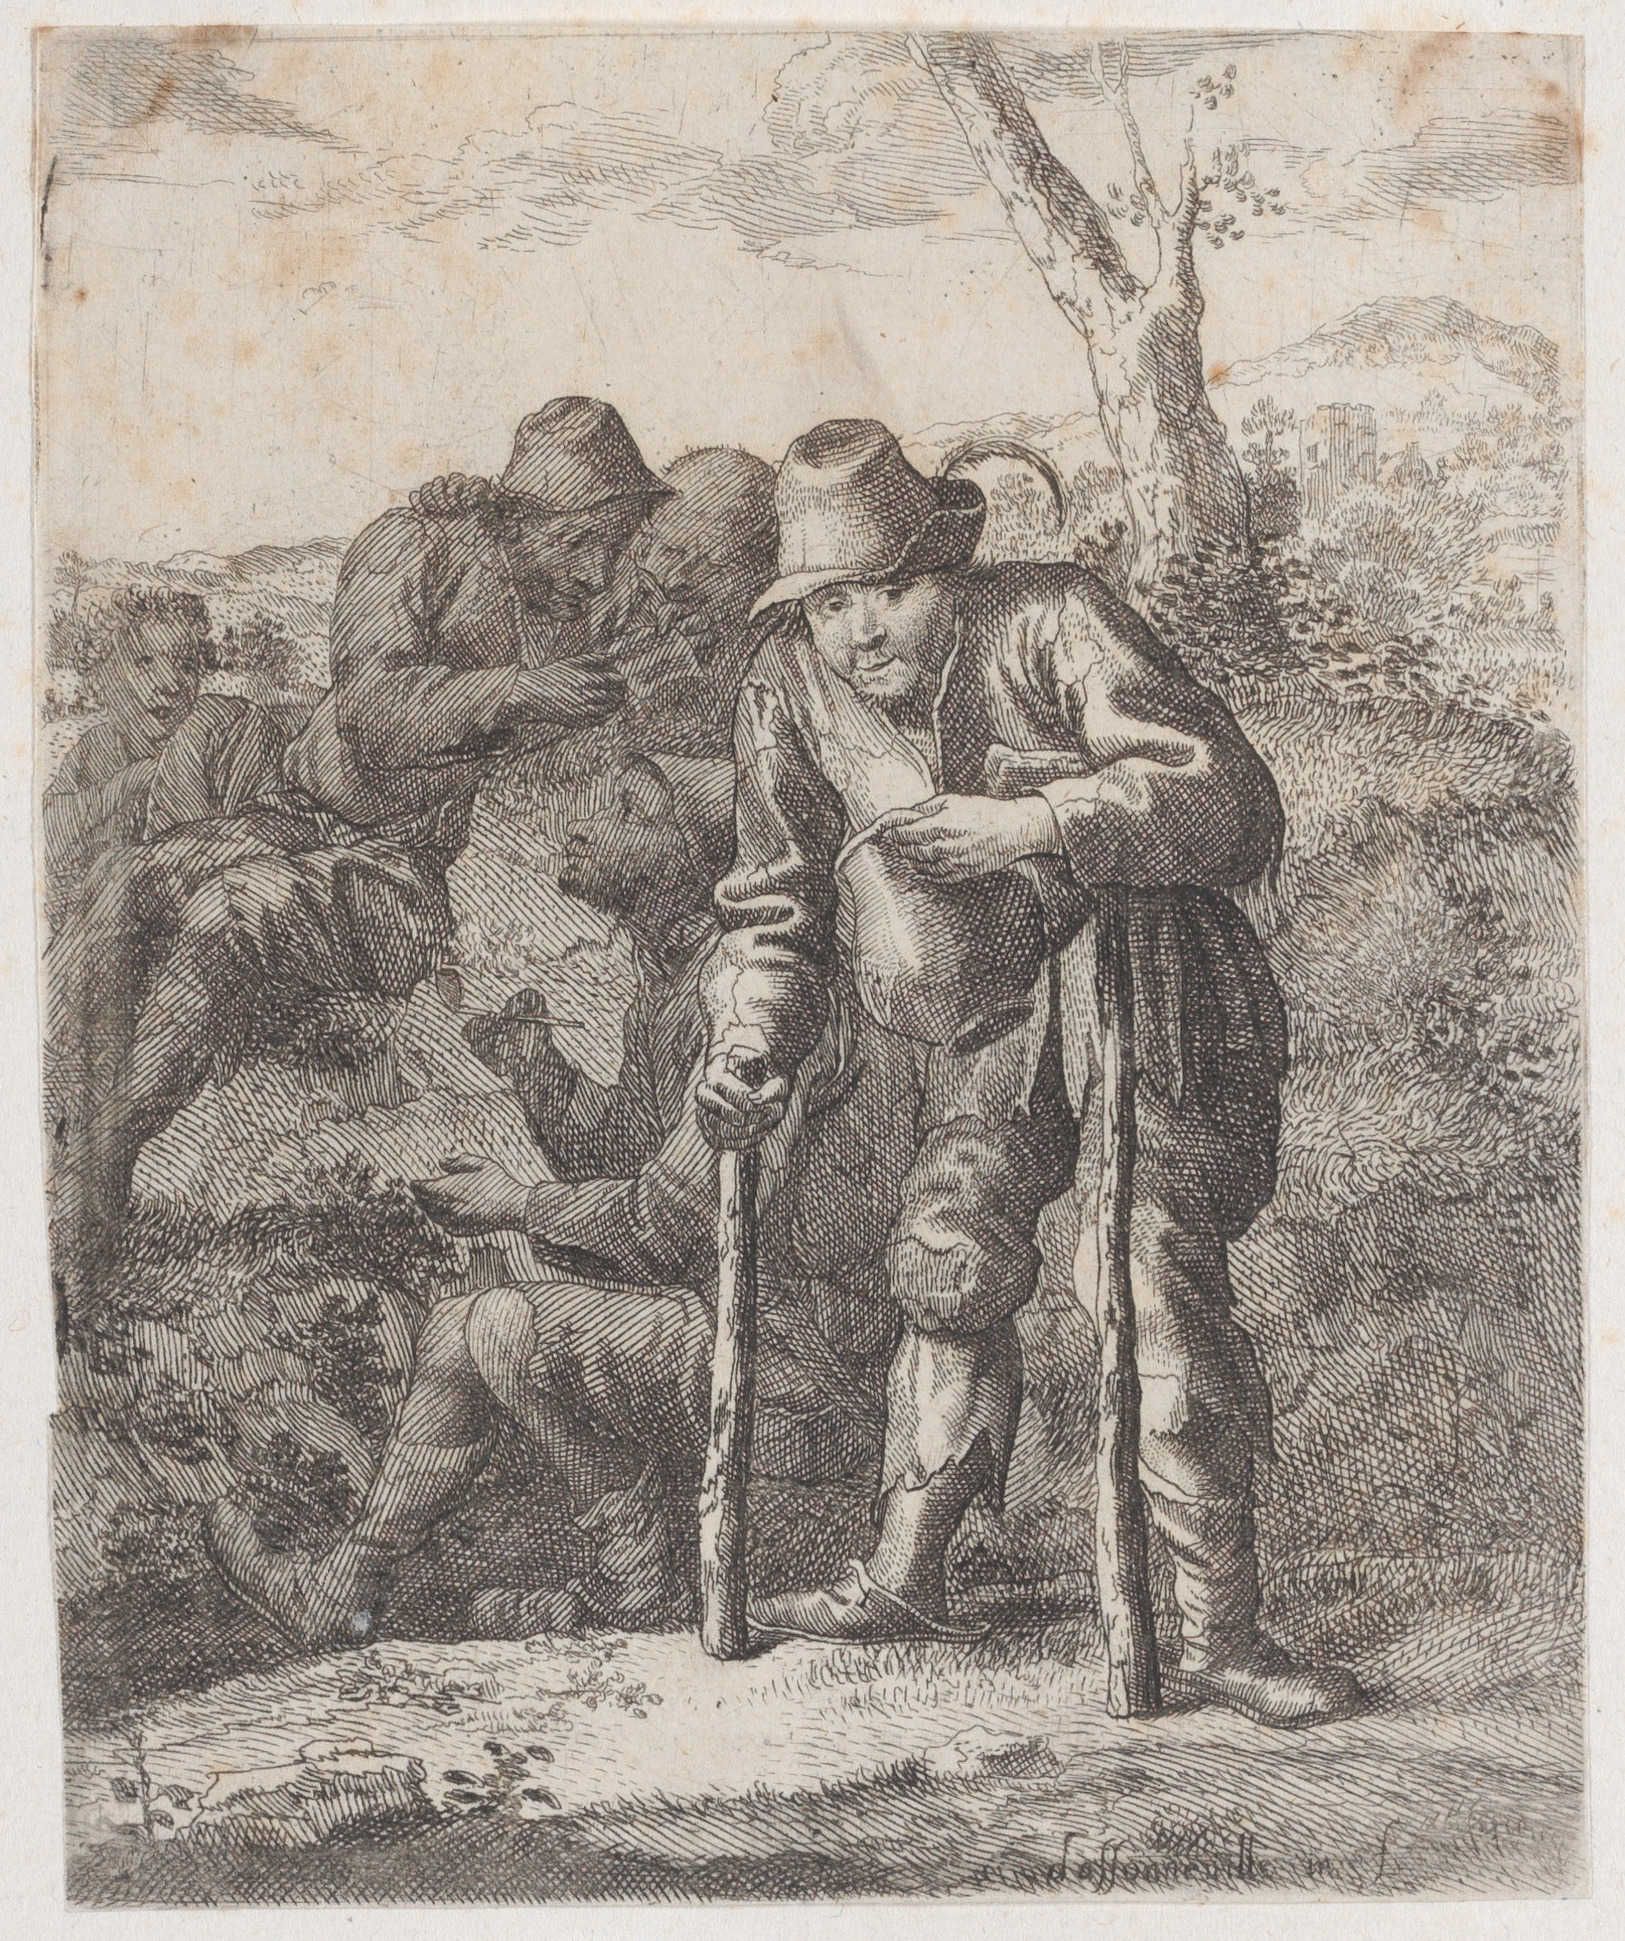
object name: print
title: Five beggars in the countryside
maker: jacques dassonville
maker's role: artist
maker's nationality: french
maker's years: 1614-1675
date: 1640-1670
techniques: etching